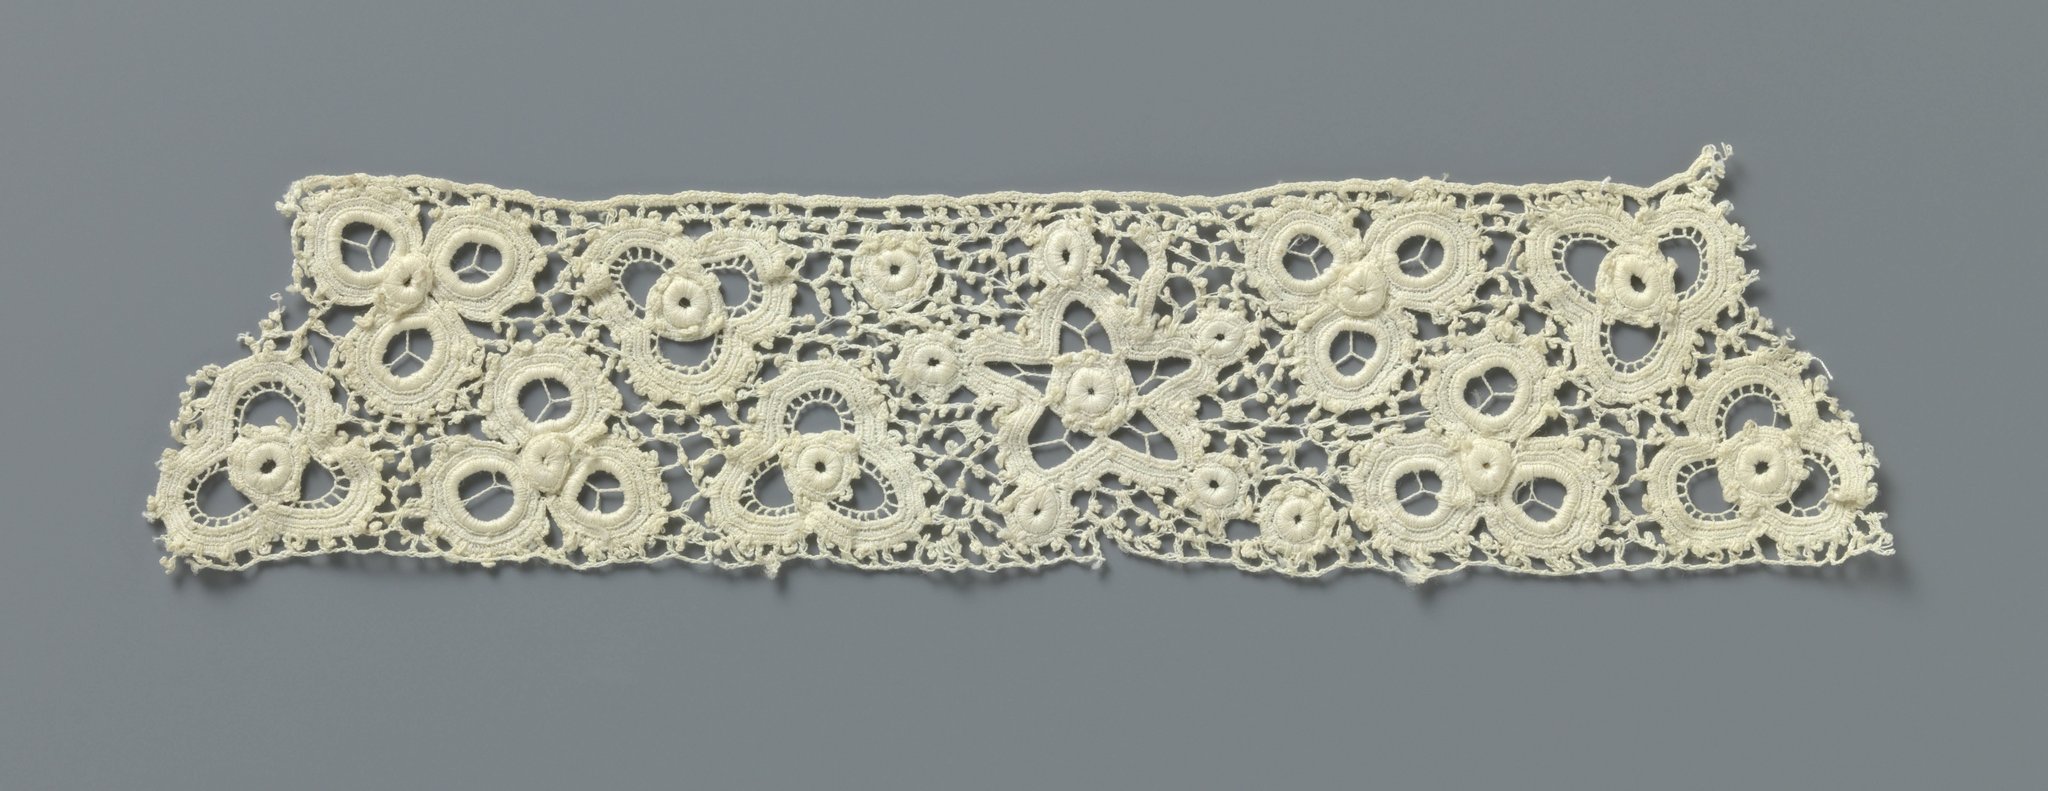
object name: strip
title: Strook gehaakte kant met vijfpuntige sterren en bloemen gemaakt met open cirkels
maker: Anonymous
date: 1890-1909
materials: cotton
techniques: crocheted lace, irish crochet lace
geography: ireland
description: Het is een aanname dat deze Ierse gehaakte kant ook daadwerkelijk in Ierland is gemaakt. Ierse gehaakte kant kent zijn oorsprong rond 1760 en kwam vanaf 1840 in ontwikkeling. Aangezien volgens Martine Bruggeman (Kant in Europa) de Ierse haakindustrie aan het eind van de 19e eeuw gereorganiseerd werd en in populariteit groeide, is het hier beschreven stuk gedateerd rond 1890, tot 1909 vanwege de datering in het eerste decennium van populariteit van Ierse gehaakte kant volgens het Kantlexicon (Johan Coene).